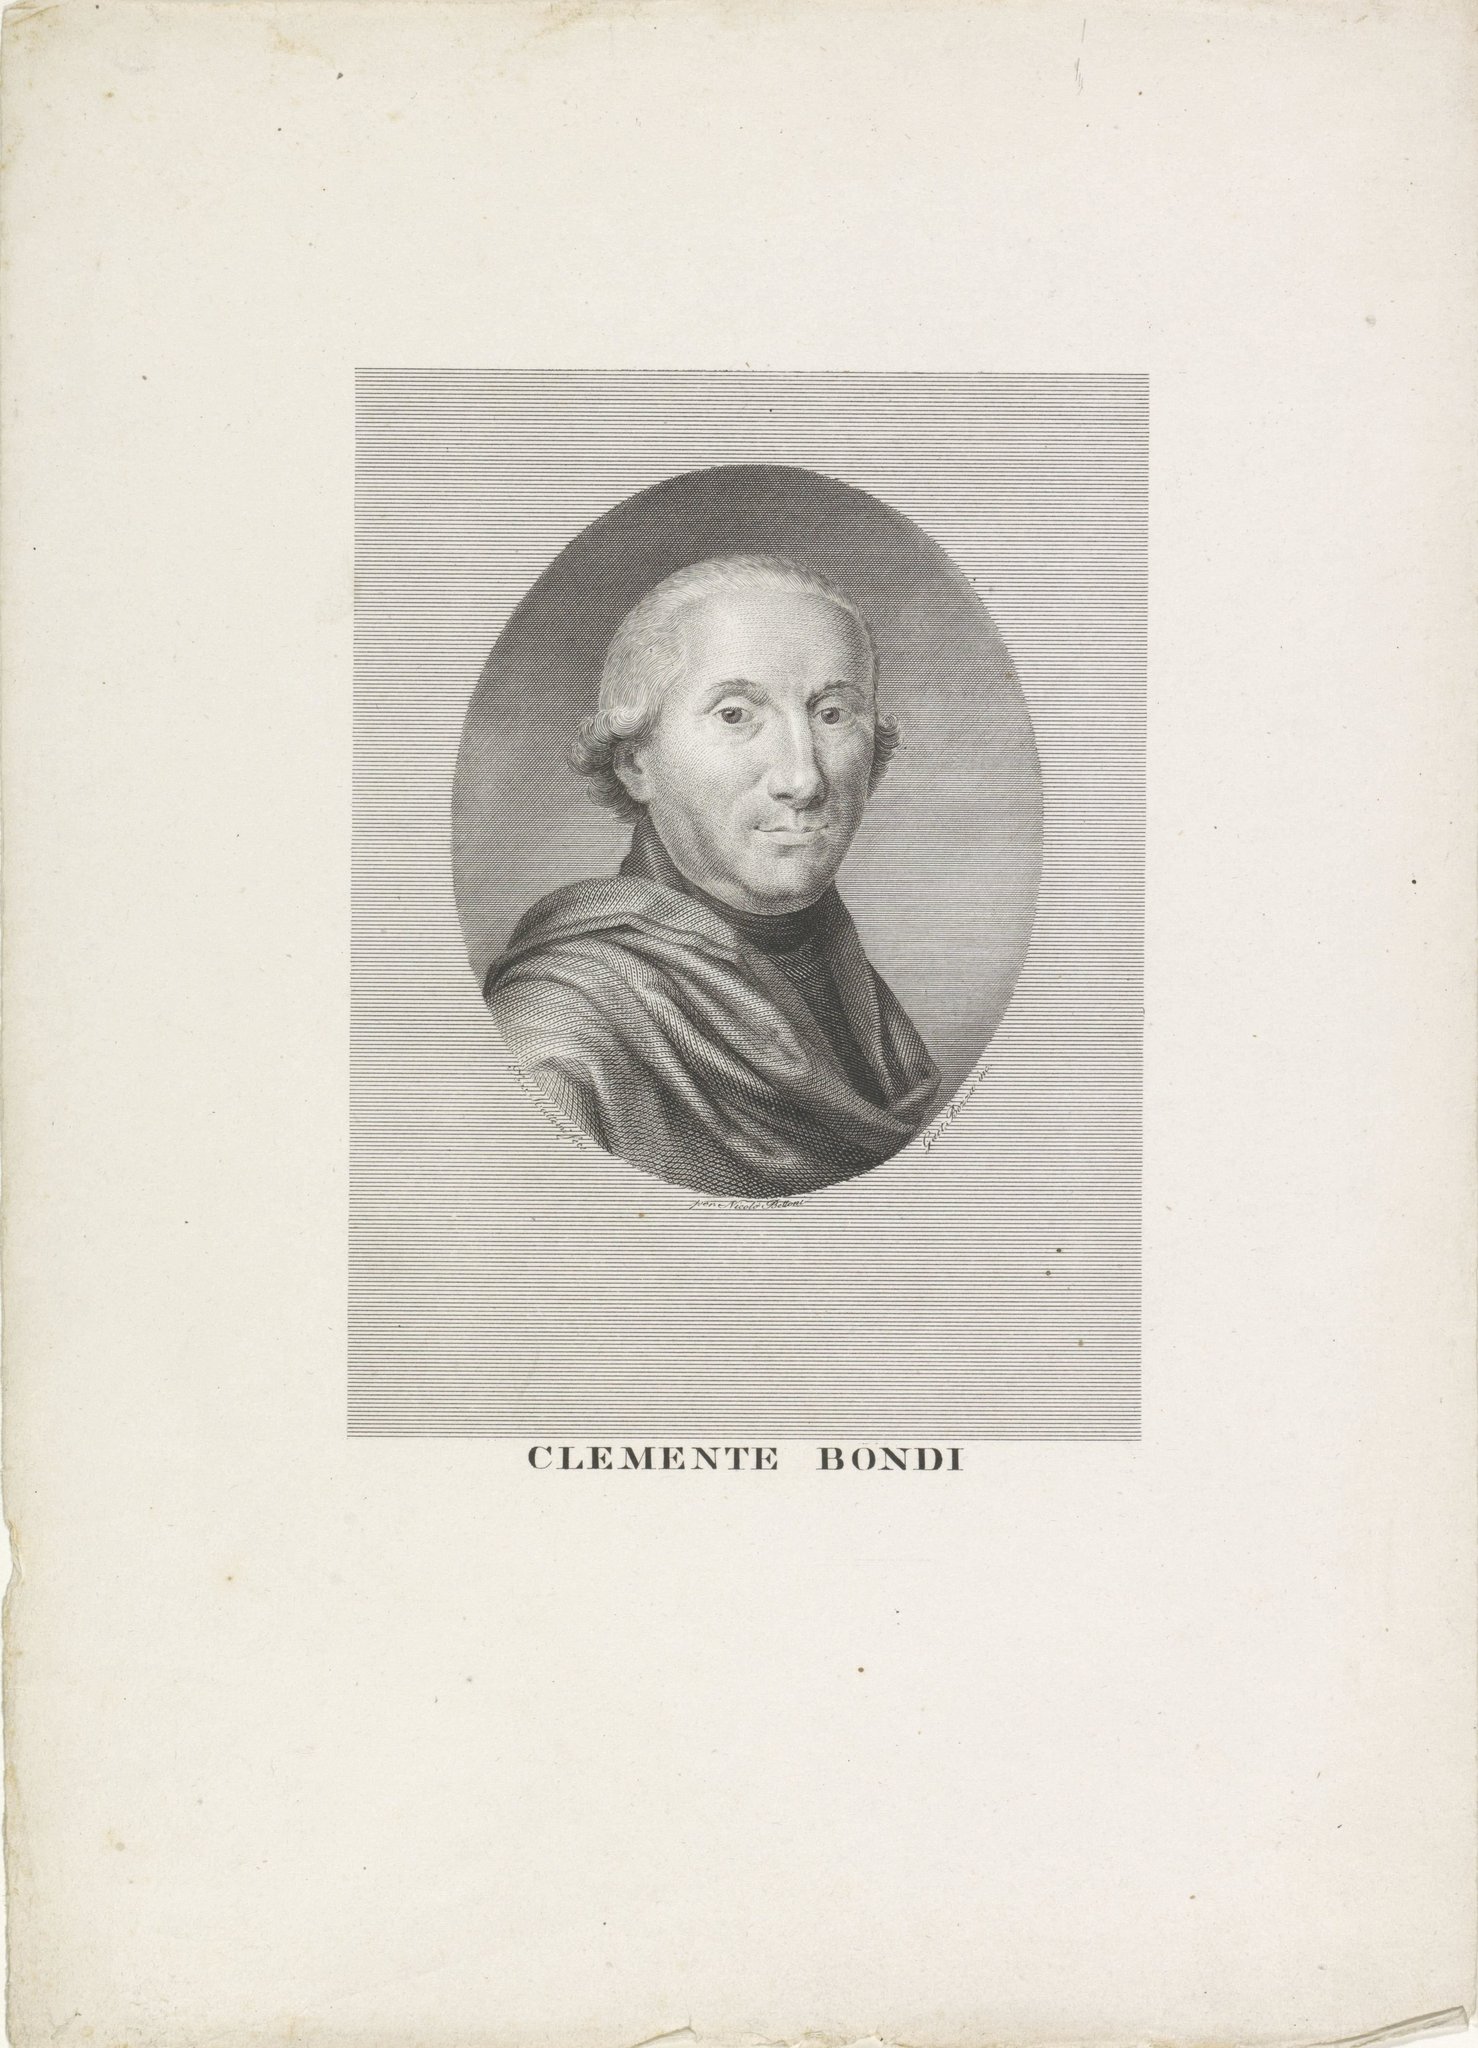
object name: print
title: Portretten van beroemde Italianen in ovalen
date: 1800-1899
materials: paper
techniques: engraving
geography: italy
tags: historical persons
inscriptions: collector's mark: Lugt 2228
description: Deze prent maakt deel uit van een reeks portretprenten van onbekende omvang. De reeks is in meerdere staten uitgegeven. De eerste staat met enkel het portret in ovaal. Een tweede staat met naam van de geportretteerde in holle letters onder de voorstelling. Een derde staat met de naam van de geportretteerde in gevulde letters onder de voorstelling. En een vierde staat met een rechthoekig kader rondom het ovale portret.